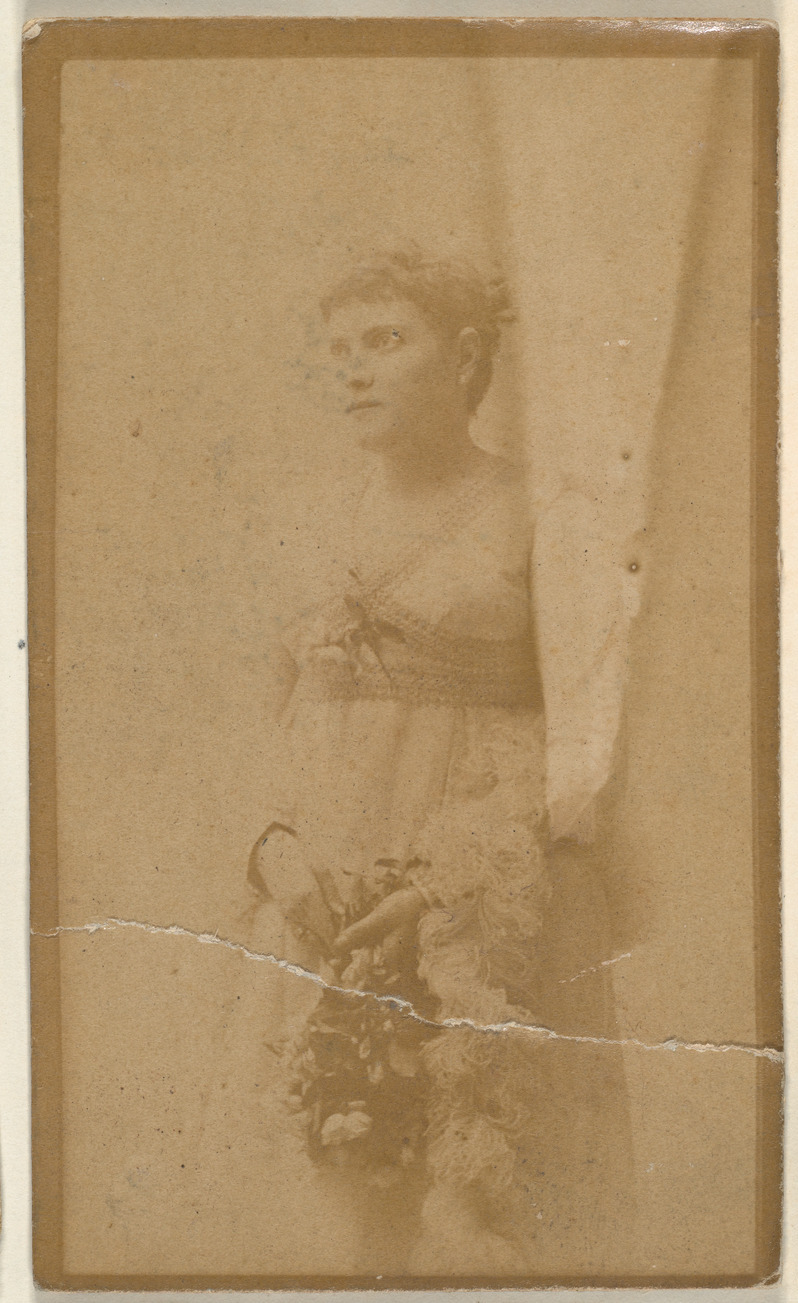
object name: photograph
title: Actress holding headpiece of floral vines, from the Actresses series (N668)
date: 1888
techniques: albumen silver print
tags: portraits,women,actresses